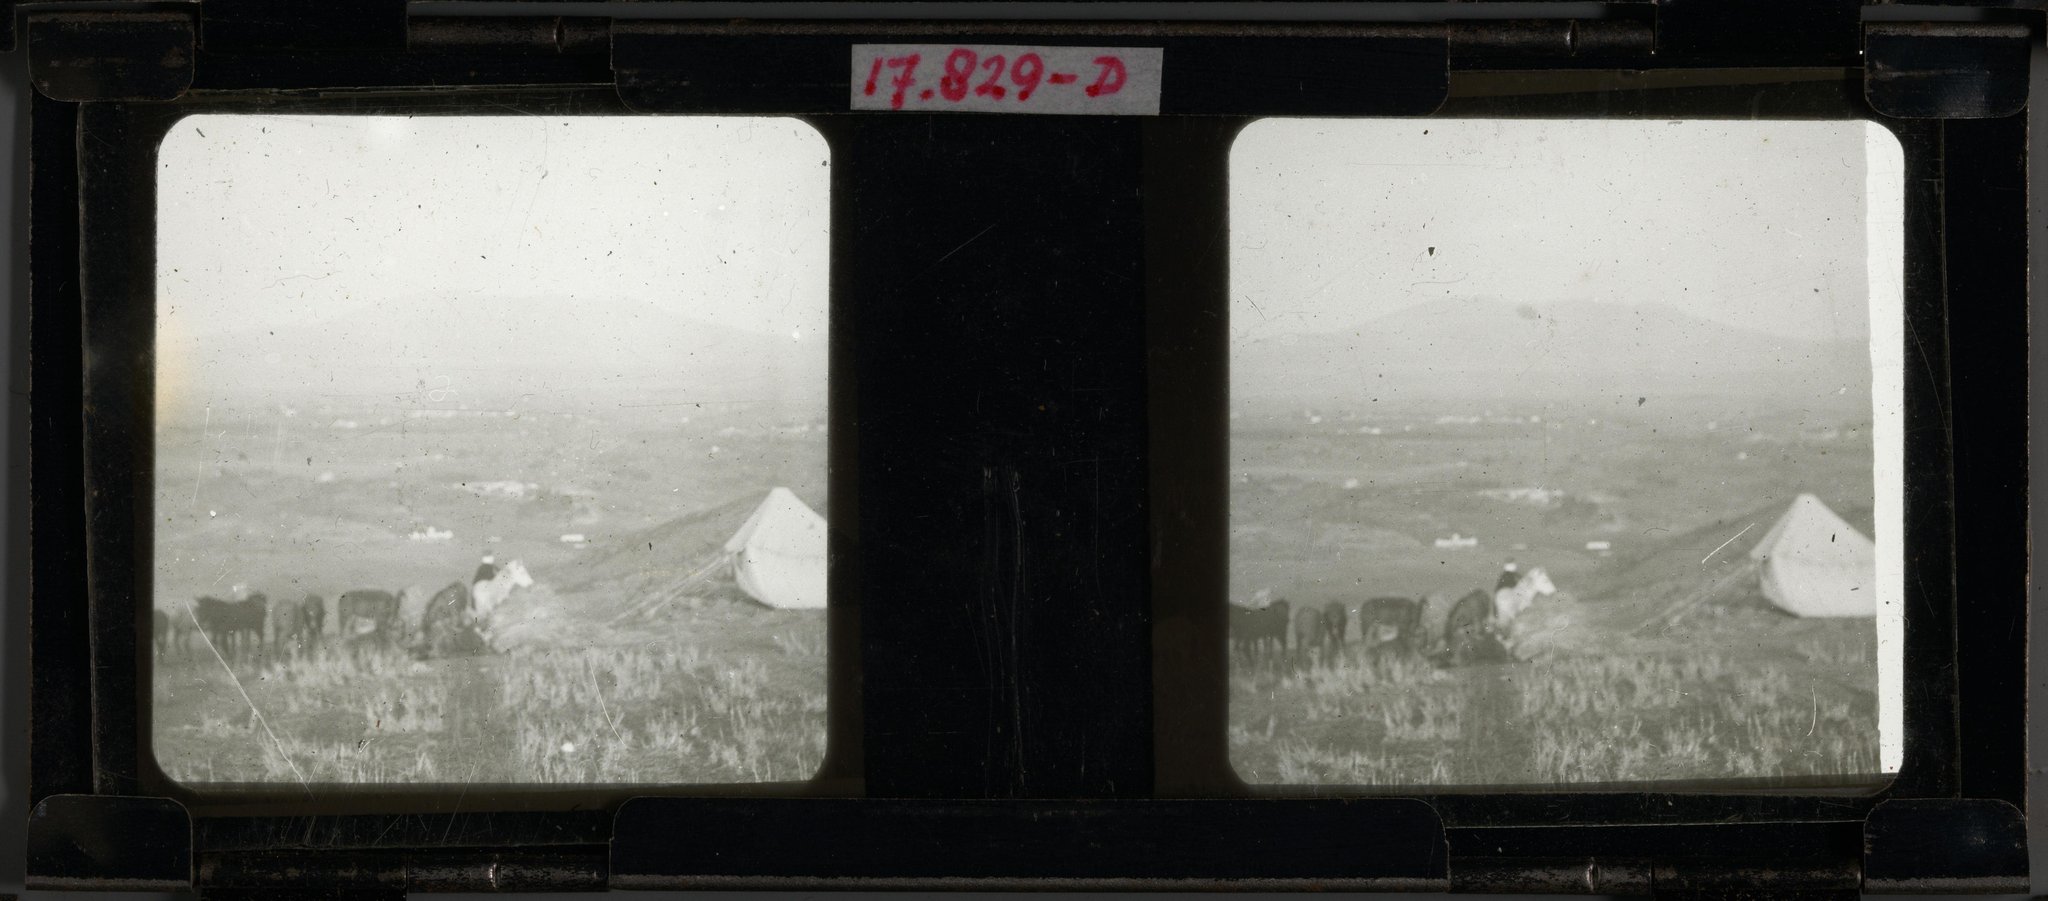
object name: album leaf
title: Paarden en een tent in heuvelachtig landschap, Noorwegen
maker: Anonymous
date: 1893-1923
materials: glass, metal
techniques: slide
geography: paris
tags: low hill country, tent-camp, horse, norway